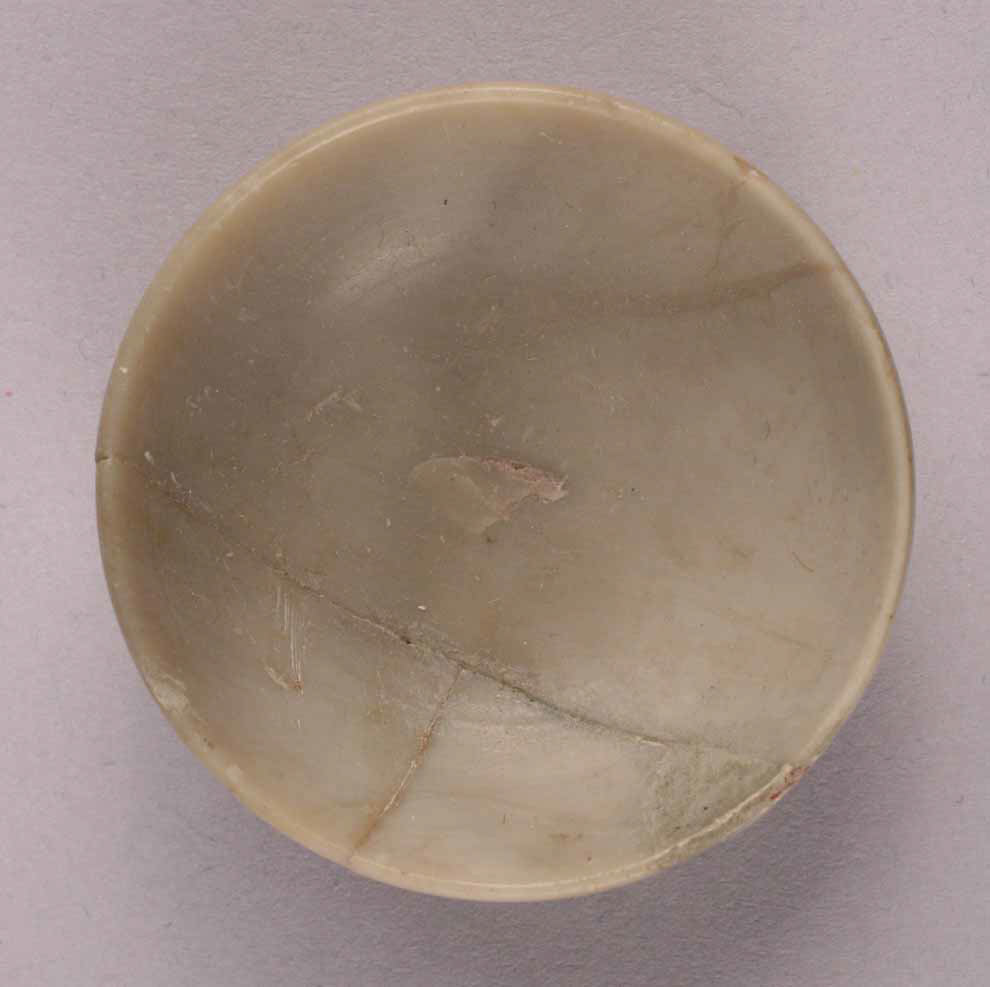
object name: bowl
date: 701-900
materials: stone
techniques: carving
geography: iran